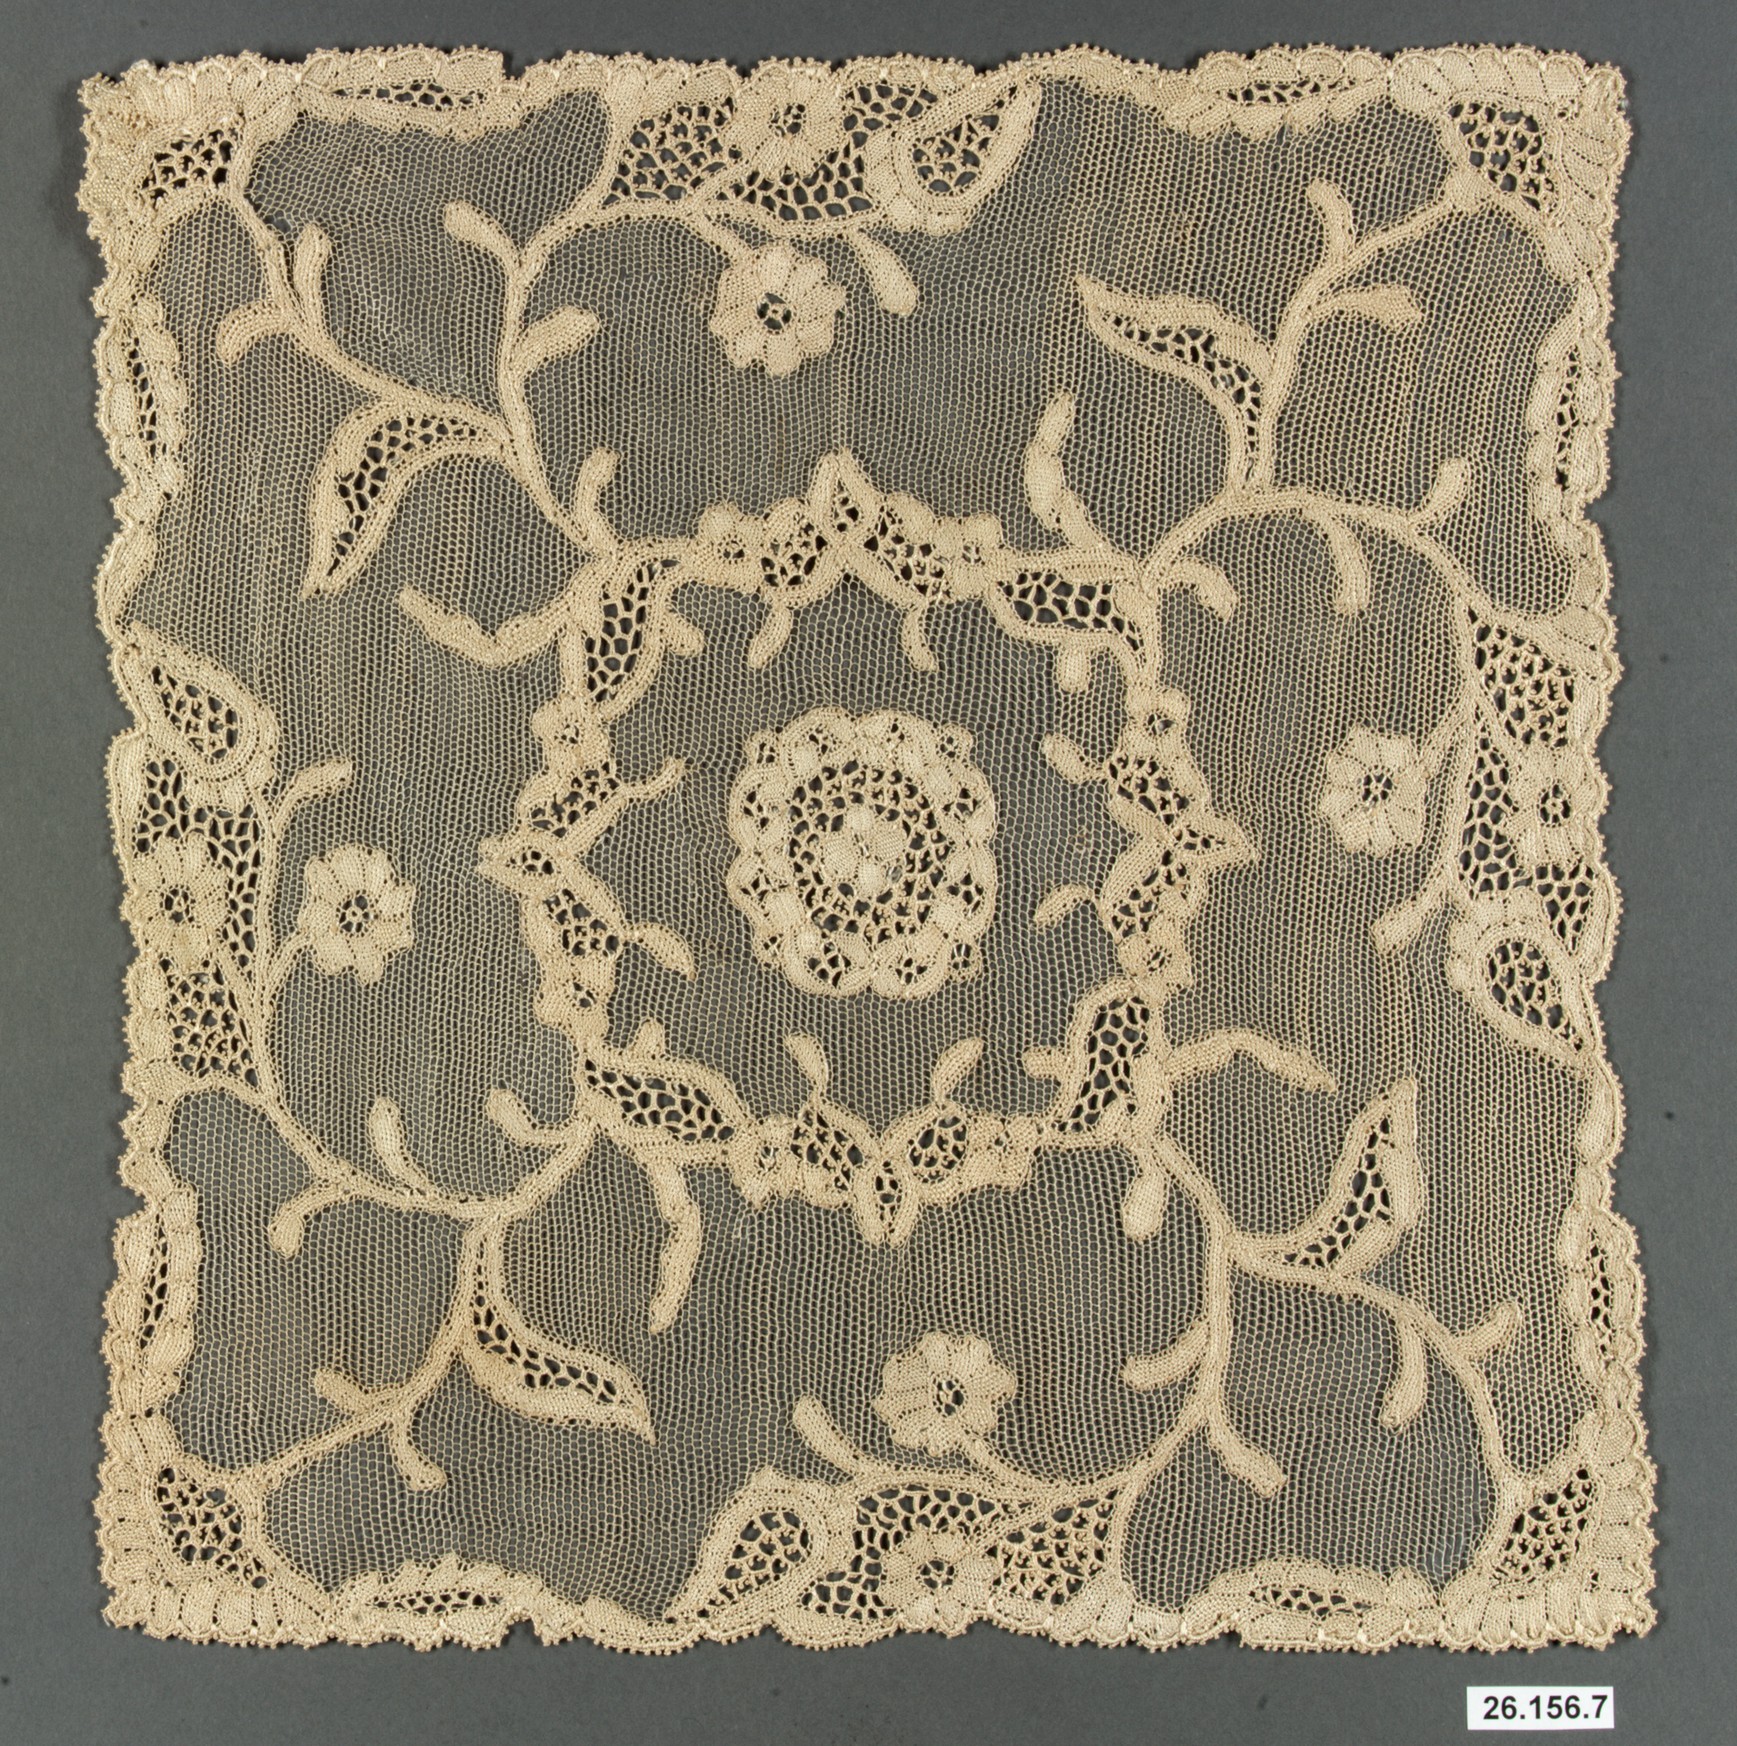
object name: square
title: Square (one of three)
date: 1701-1800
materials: silk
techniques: lace